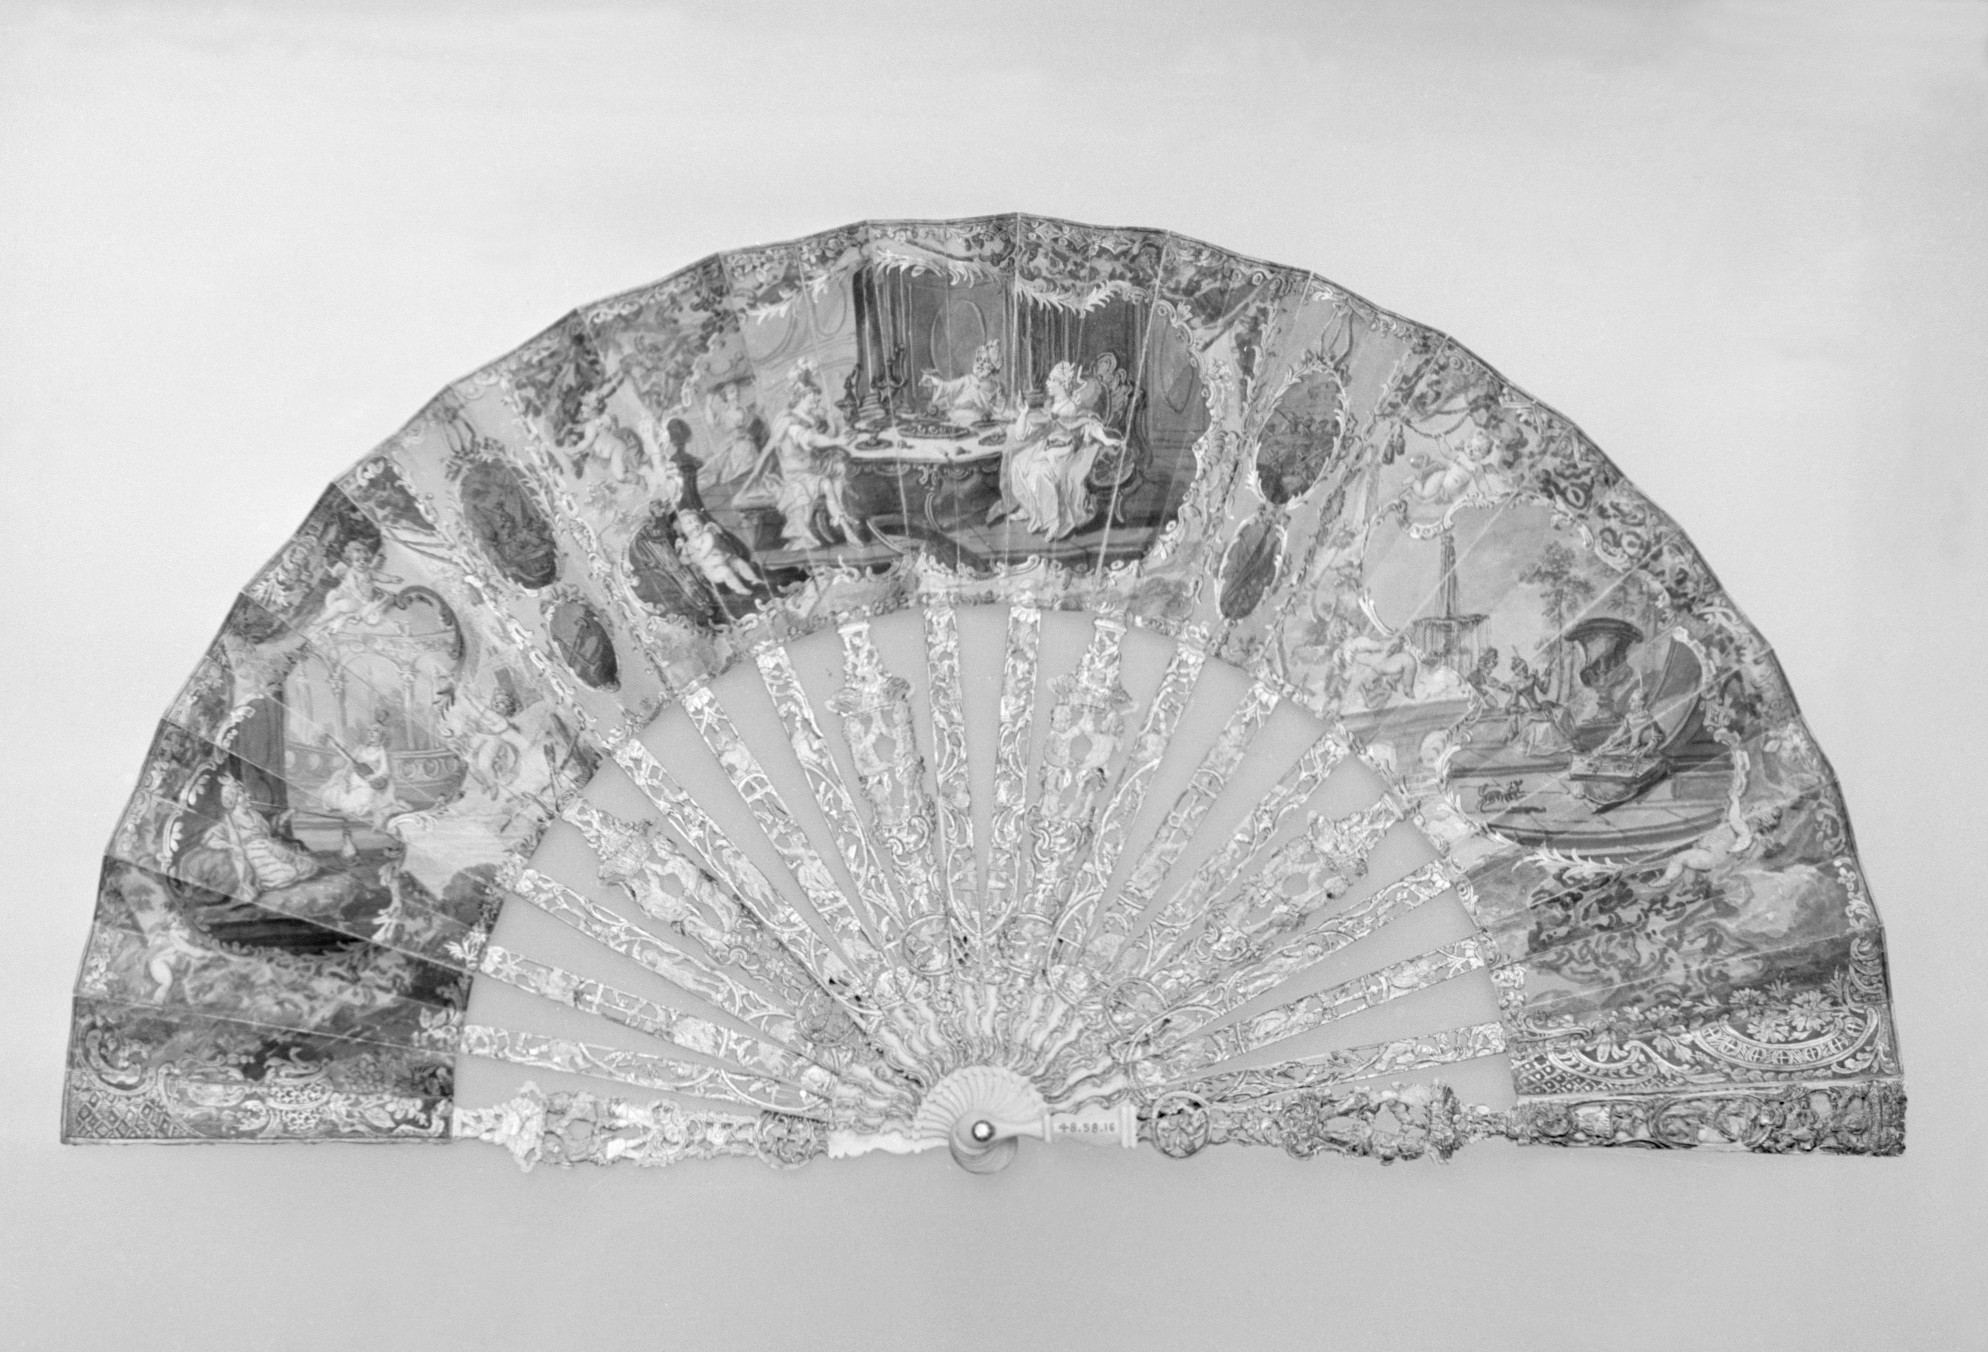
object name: fan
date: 1751-1775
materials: gold, ivory, paper, silver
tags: men,women,banquets